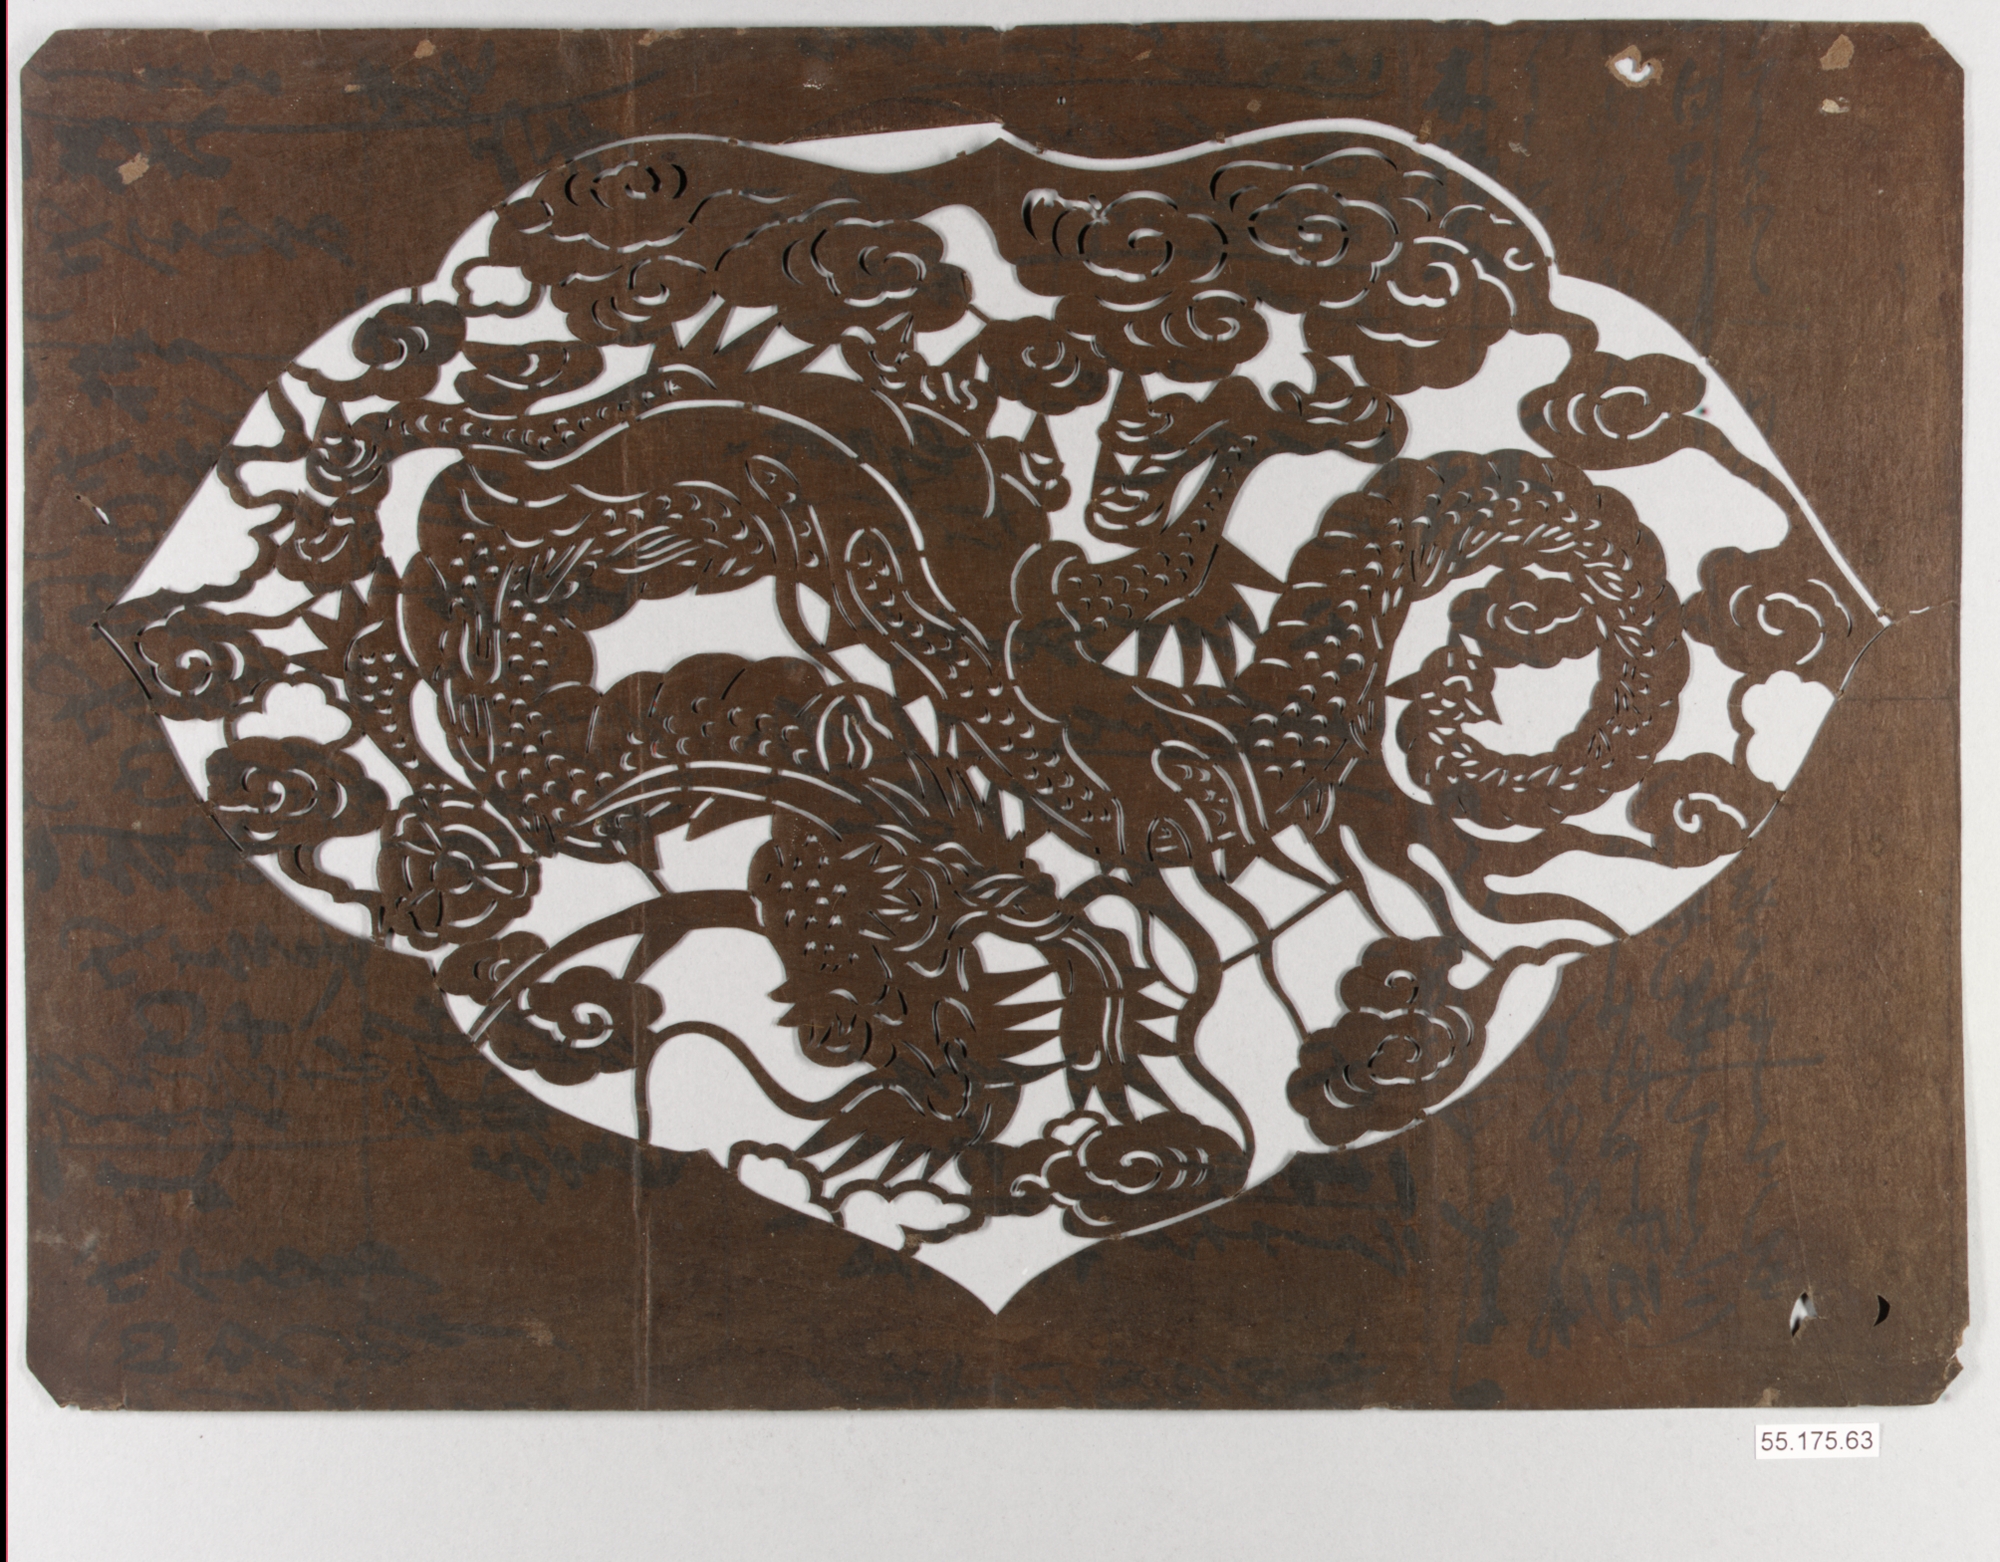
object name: stencil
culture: japanese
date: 1801-1900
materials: paper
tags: dragons